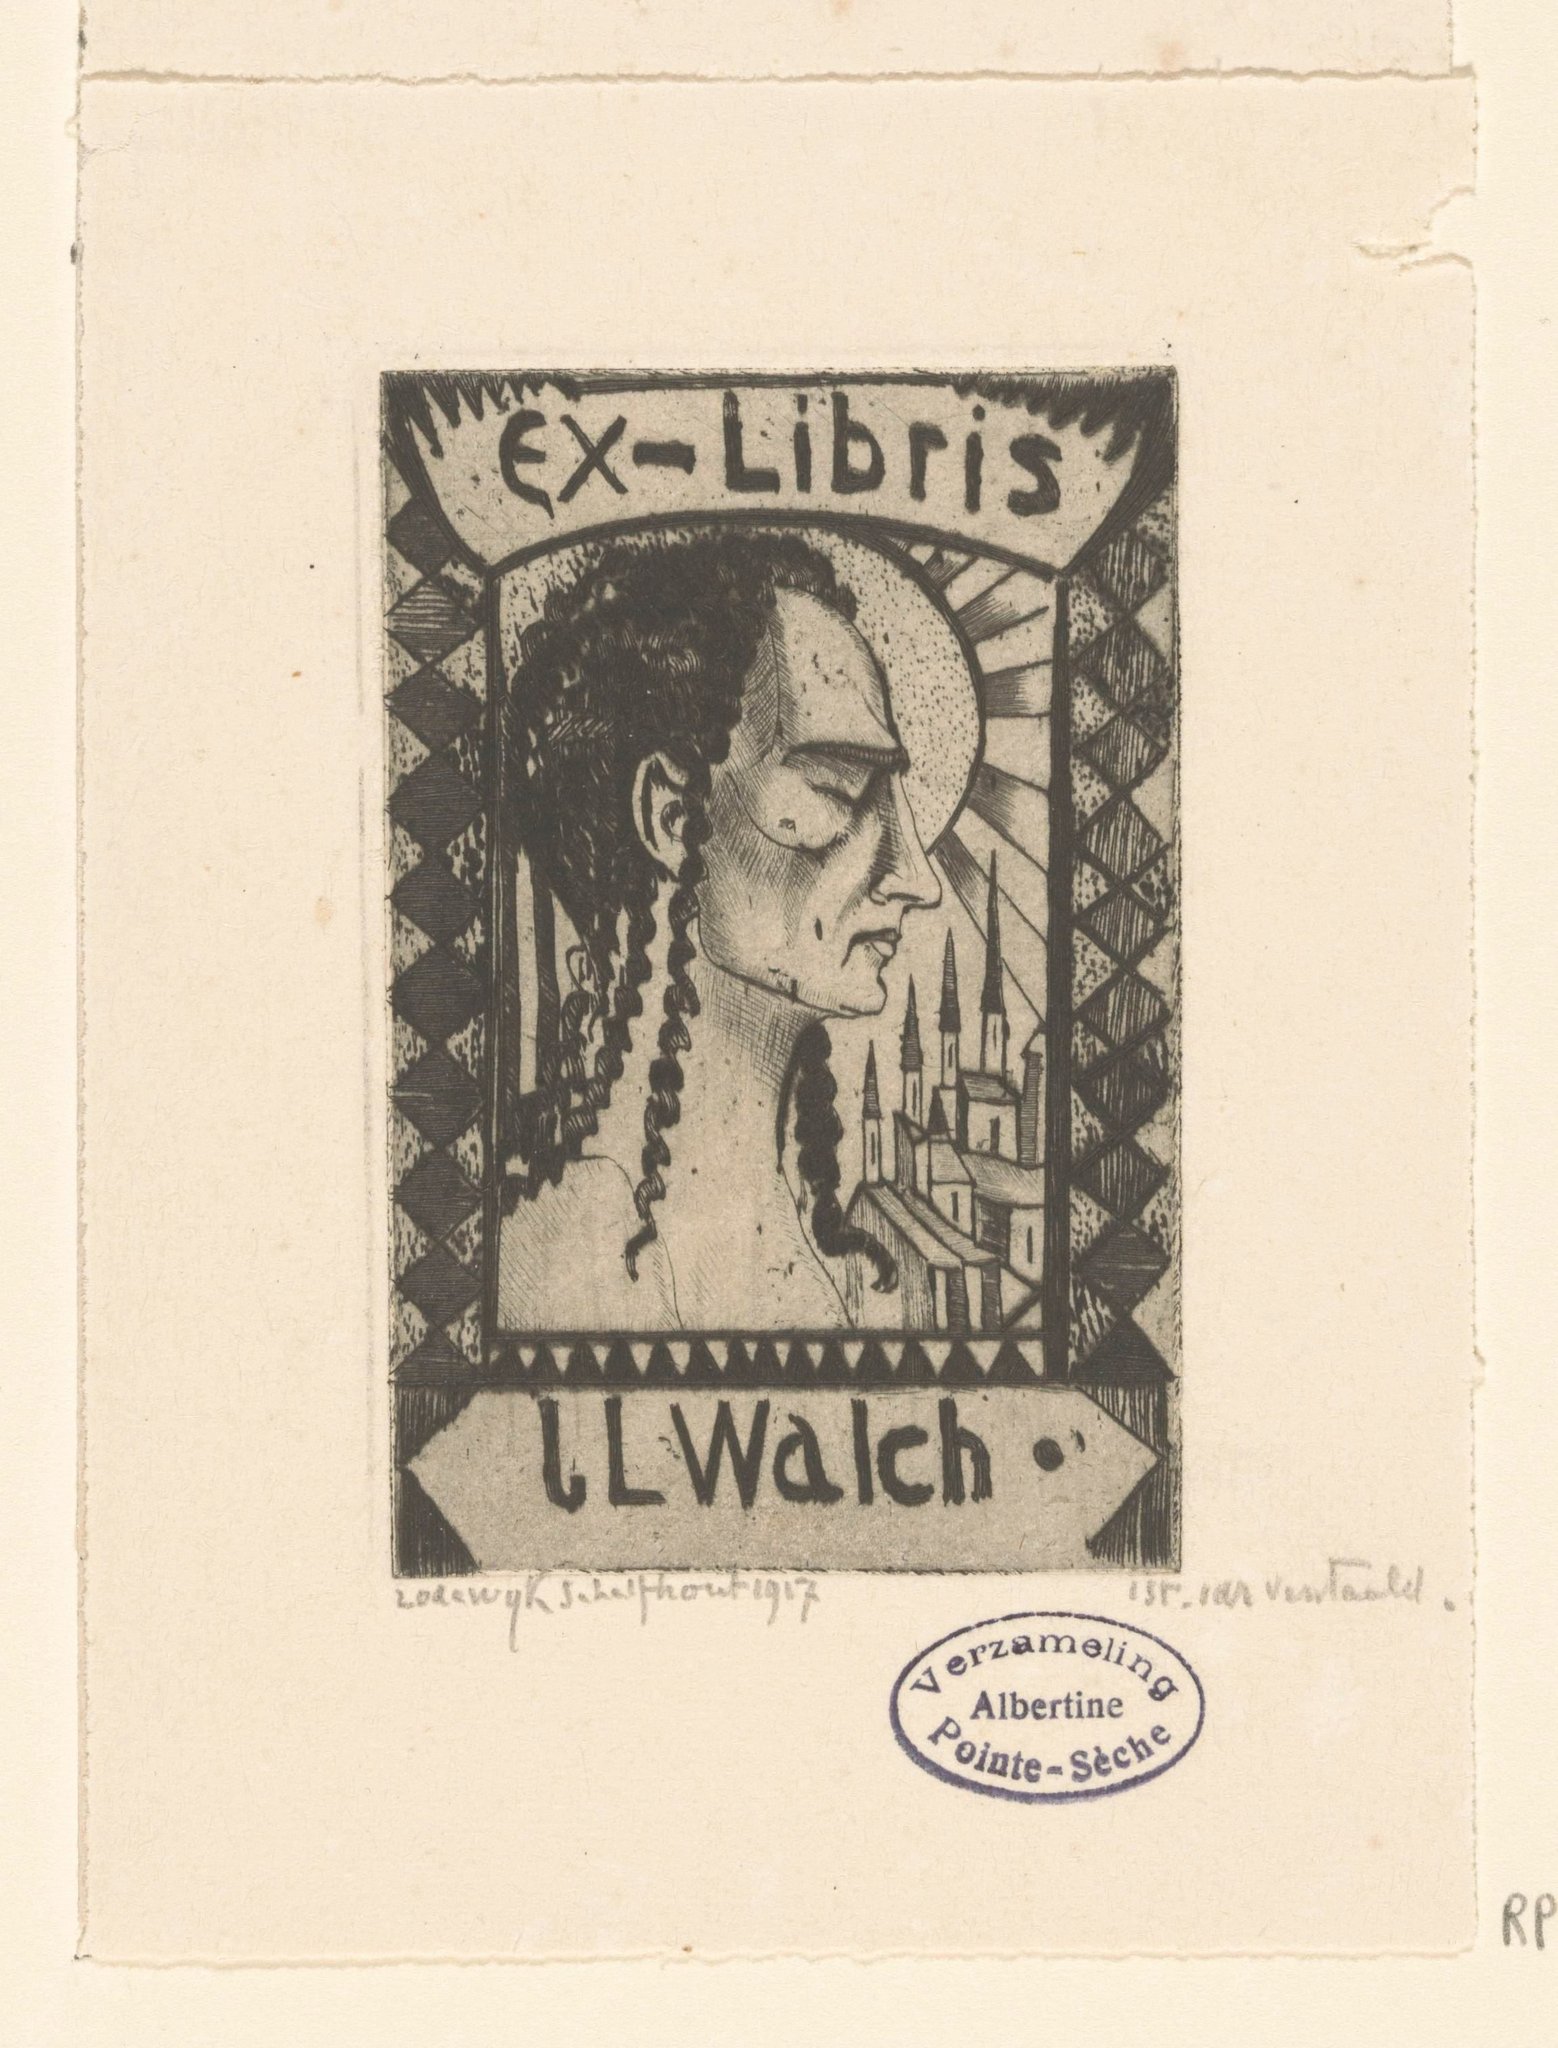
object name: print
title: Ex libris van Jan Walch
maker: lodewijk schelfhout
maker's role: draughtsman, print maker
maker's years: 1881-1943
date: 1917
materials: paper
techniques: drypoint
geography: netherlands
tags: nimbus, halo ~ radiance emanating from persons or things, head (human)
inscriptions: collector's mark: Lugt 2228, collector's mark: Lugt 2760, collector's mark: Lugt 5i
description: Een figuur met aureool. Op de achtergrond gebouwen met torens.